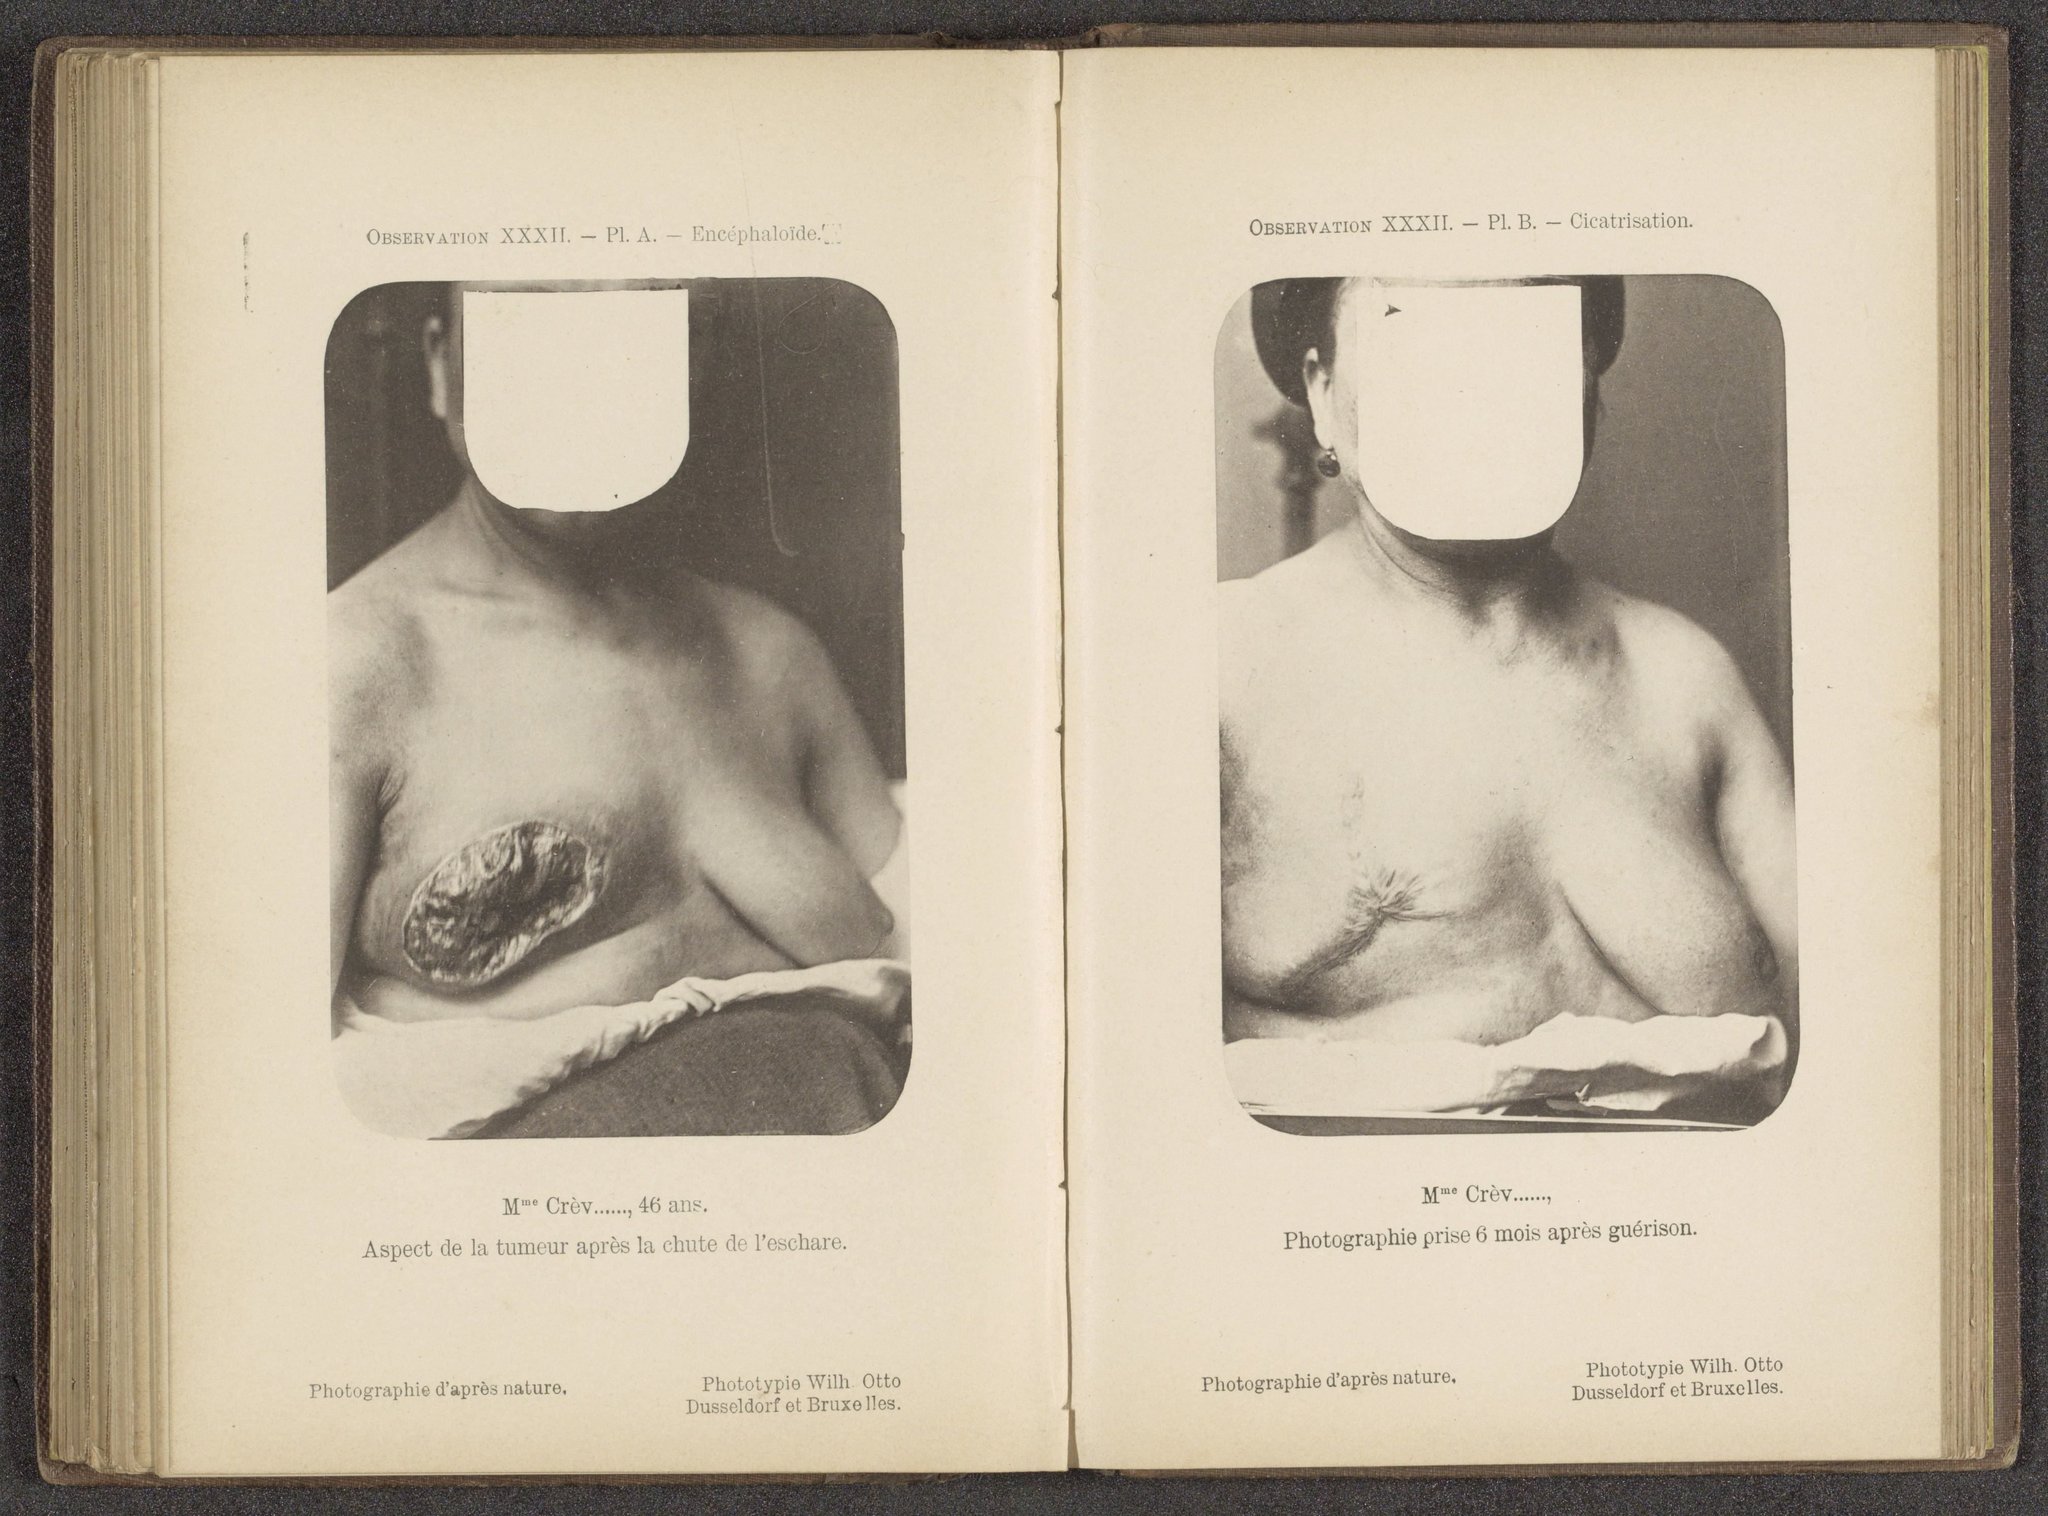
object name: page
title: Vrouw met een litteken op haar borst na het verwijderen van een borsttumor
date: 1874-1884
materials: paper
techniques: photograph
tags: tumours - aa - female human figure, scar, cicatrix - aa - female human figure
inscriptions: inscription: ‘Observation XXXII. - Pl. B. - Cicatrisation. / Mme Crèv...., / Photographie prise 6 mois après guérison.’